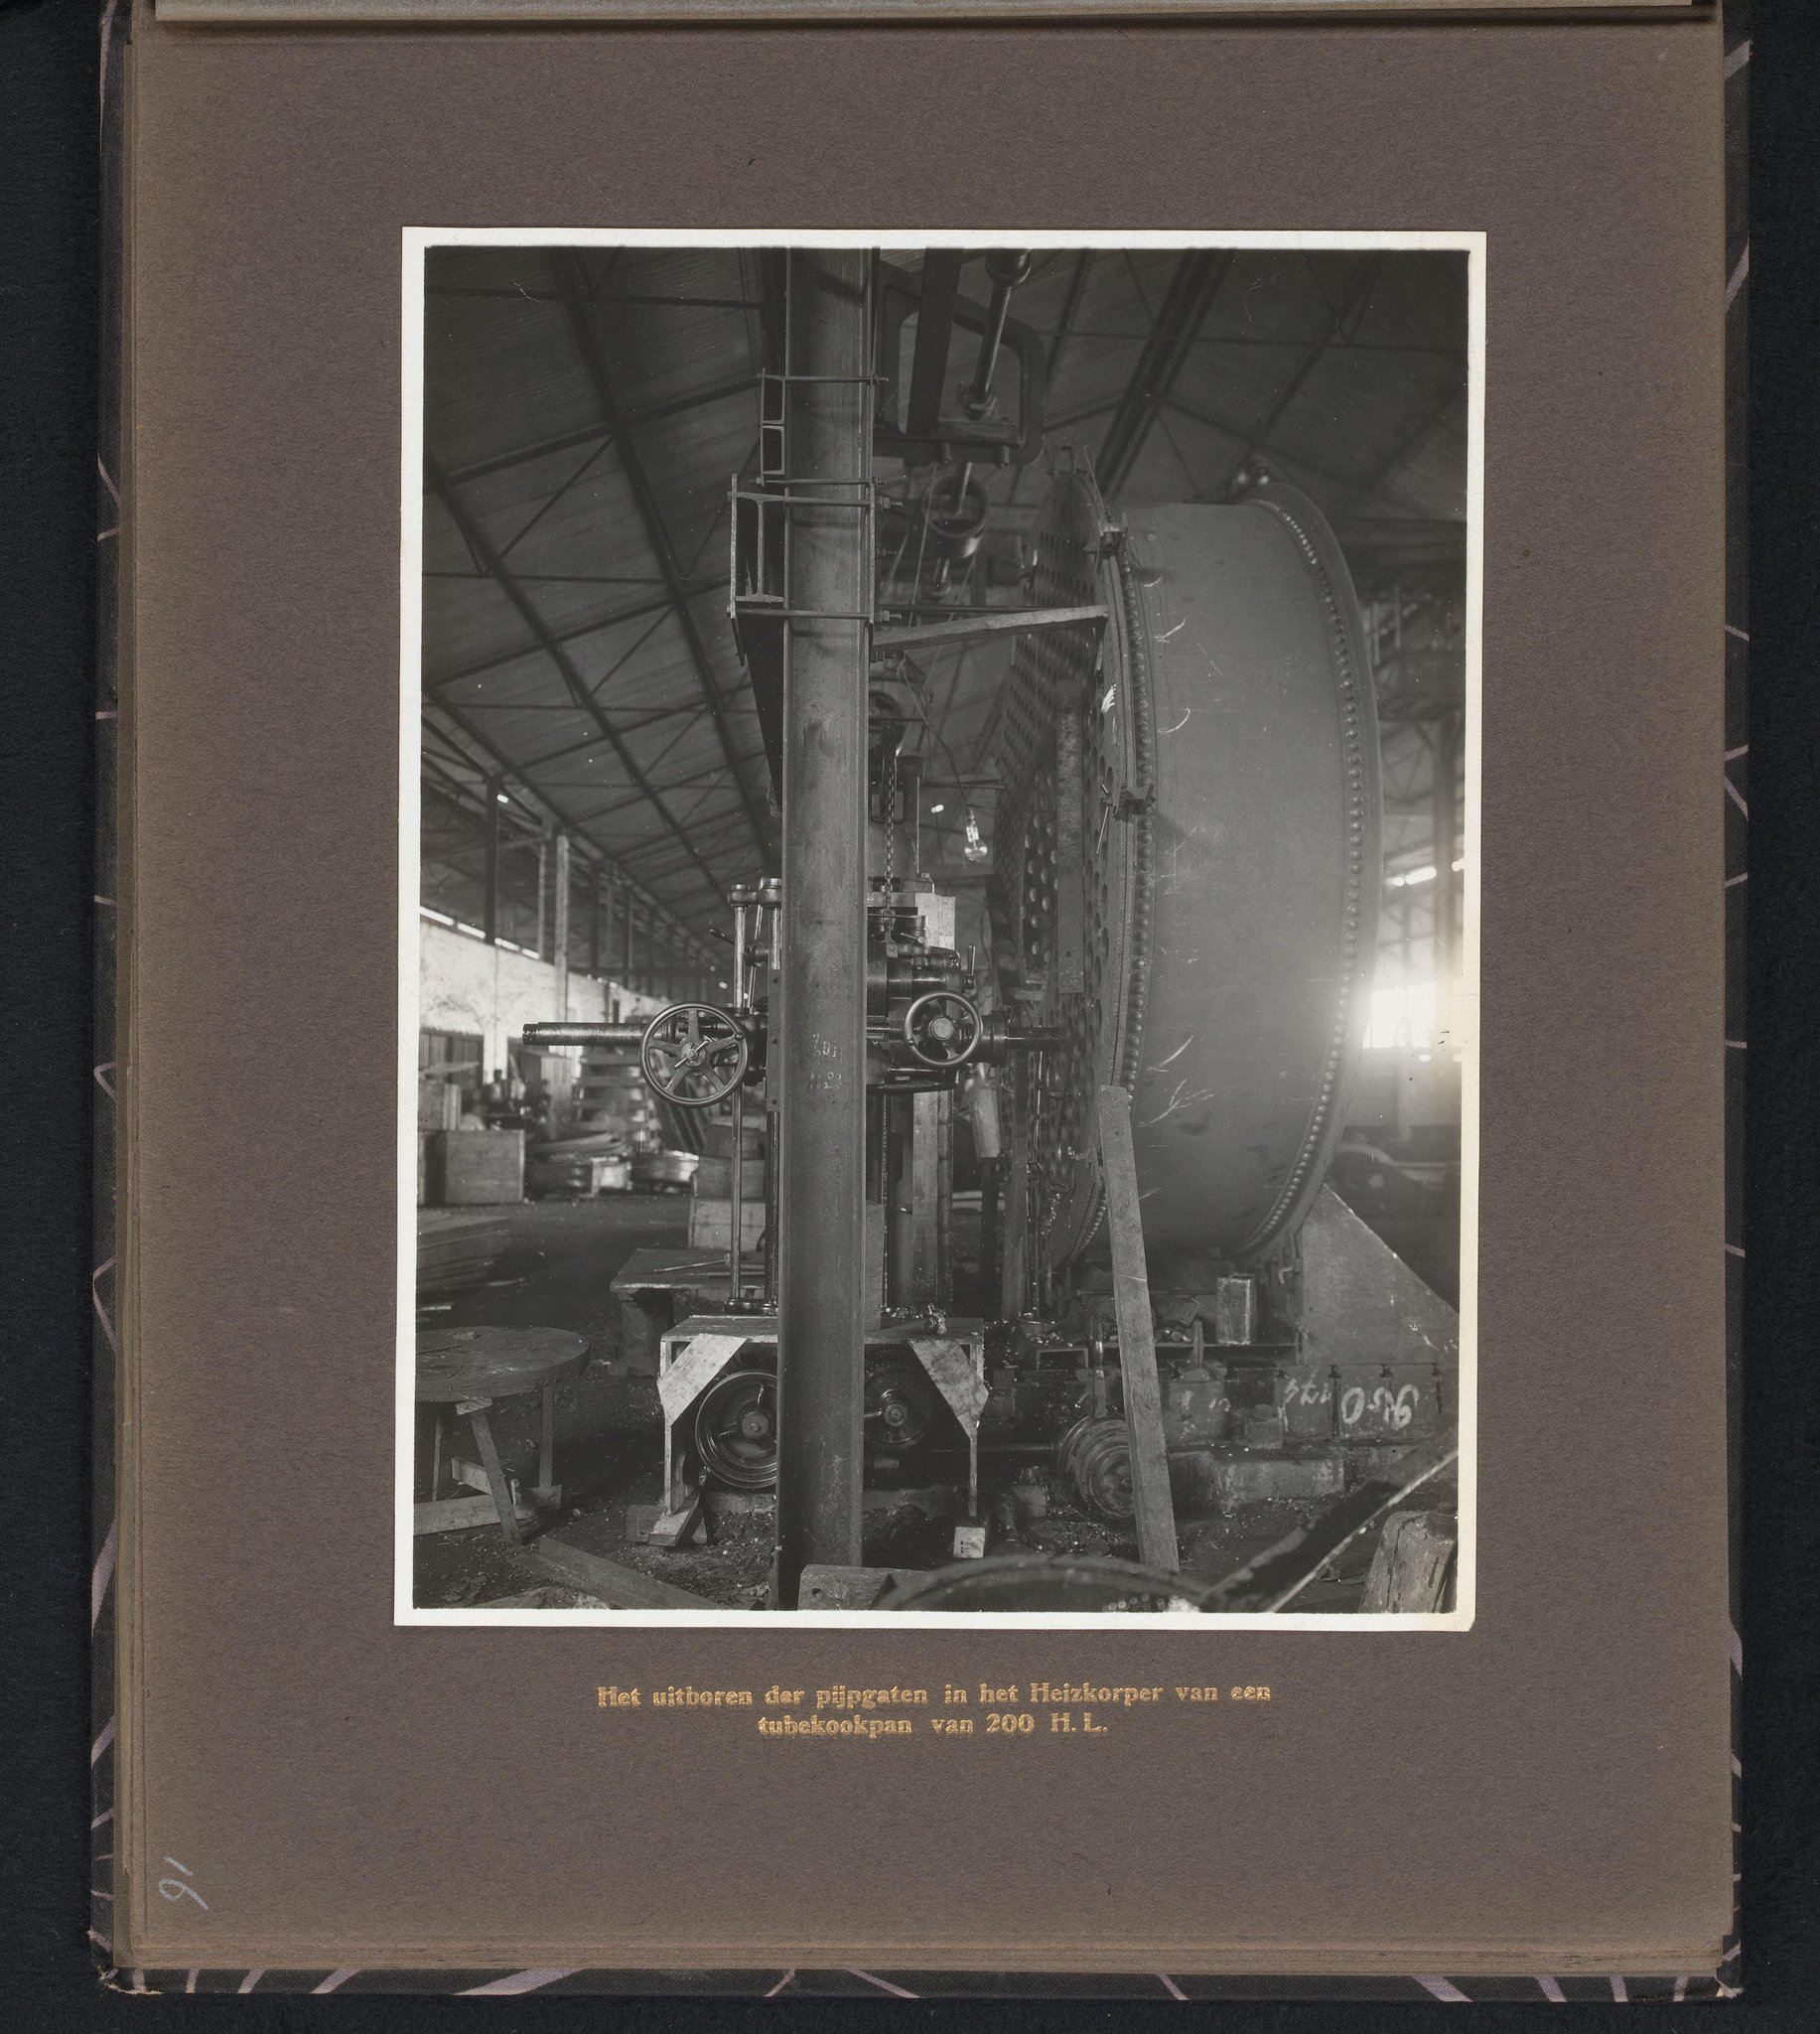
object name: photograph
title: Het uitboren per pijpgaten in het Heizkorper van een tubekookpan van 200 H.L.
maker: Anonymous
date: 1916-1924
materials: cardboard, photographic support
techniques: gelatin silver print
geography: surabaya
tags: colonial system, factory-interior, machine shop, freight train, java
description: Albumblad met een foto van de bewerking van een machine. Vervaardigd door Machinefabriek Braat. Onderdeel van het fotoalbum Machinefabriek Braat Soerabaia-Djocja-Tegal, ca. 1916-1924.